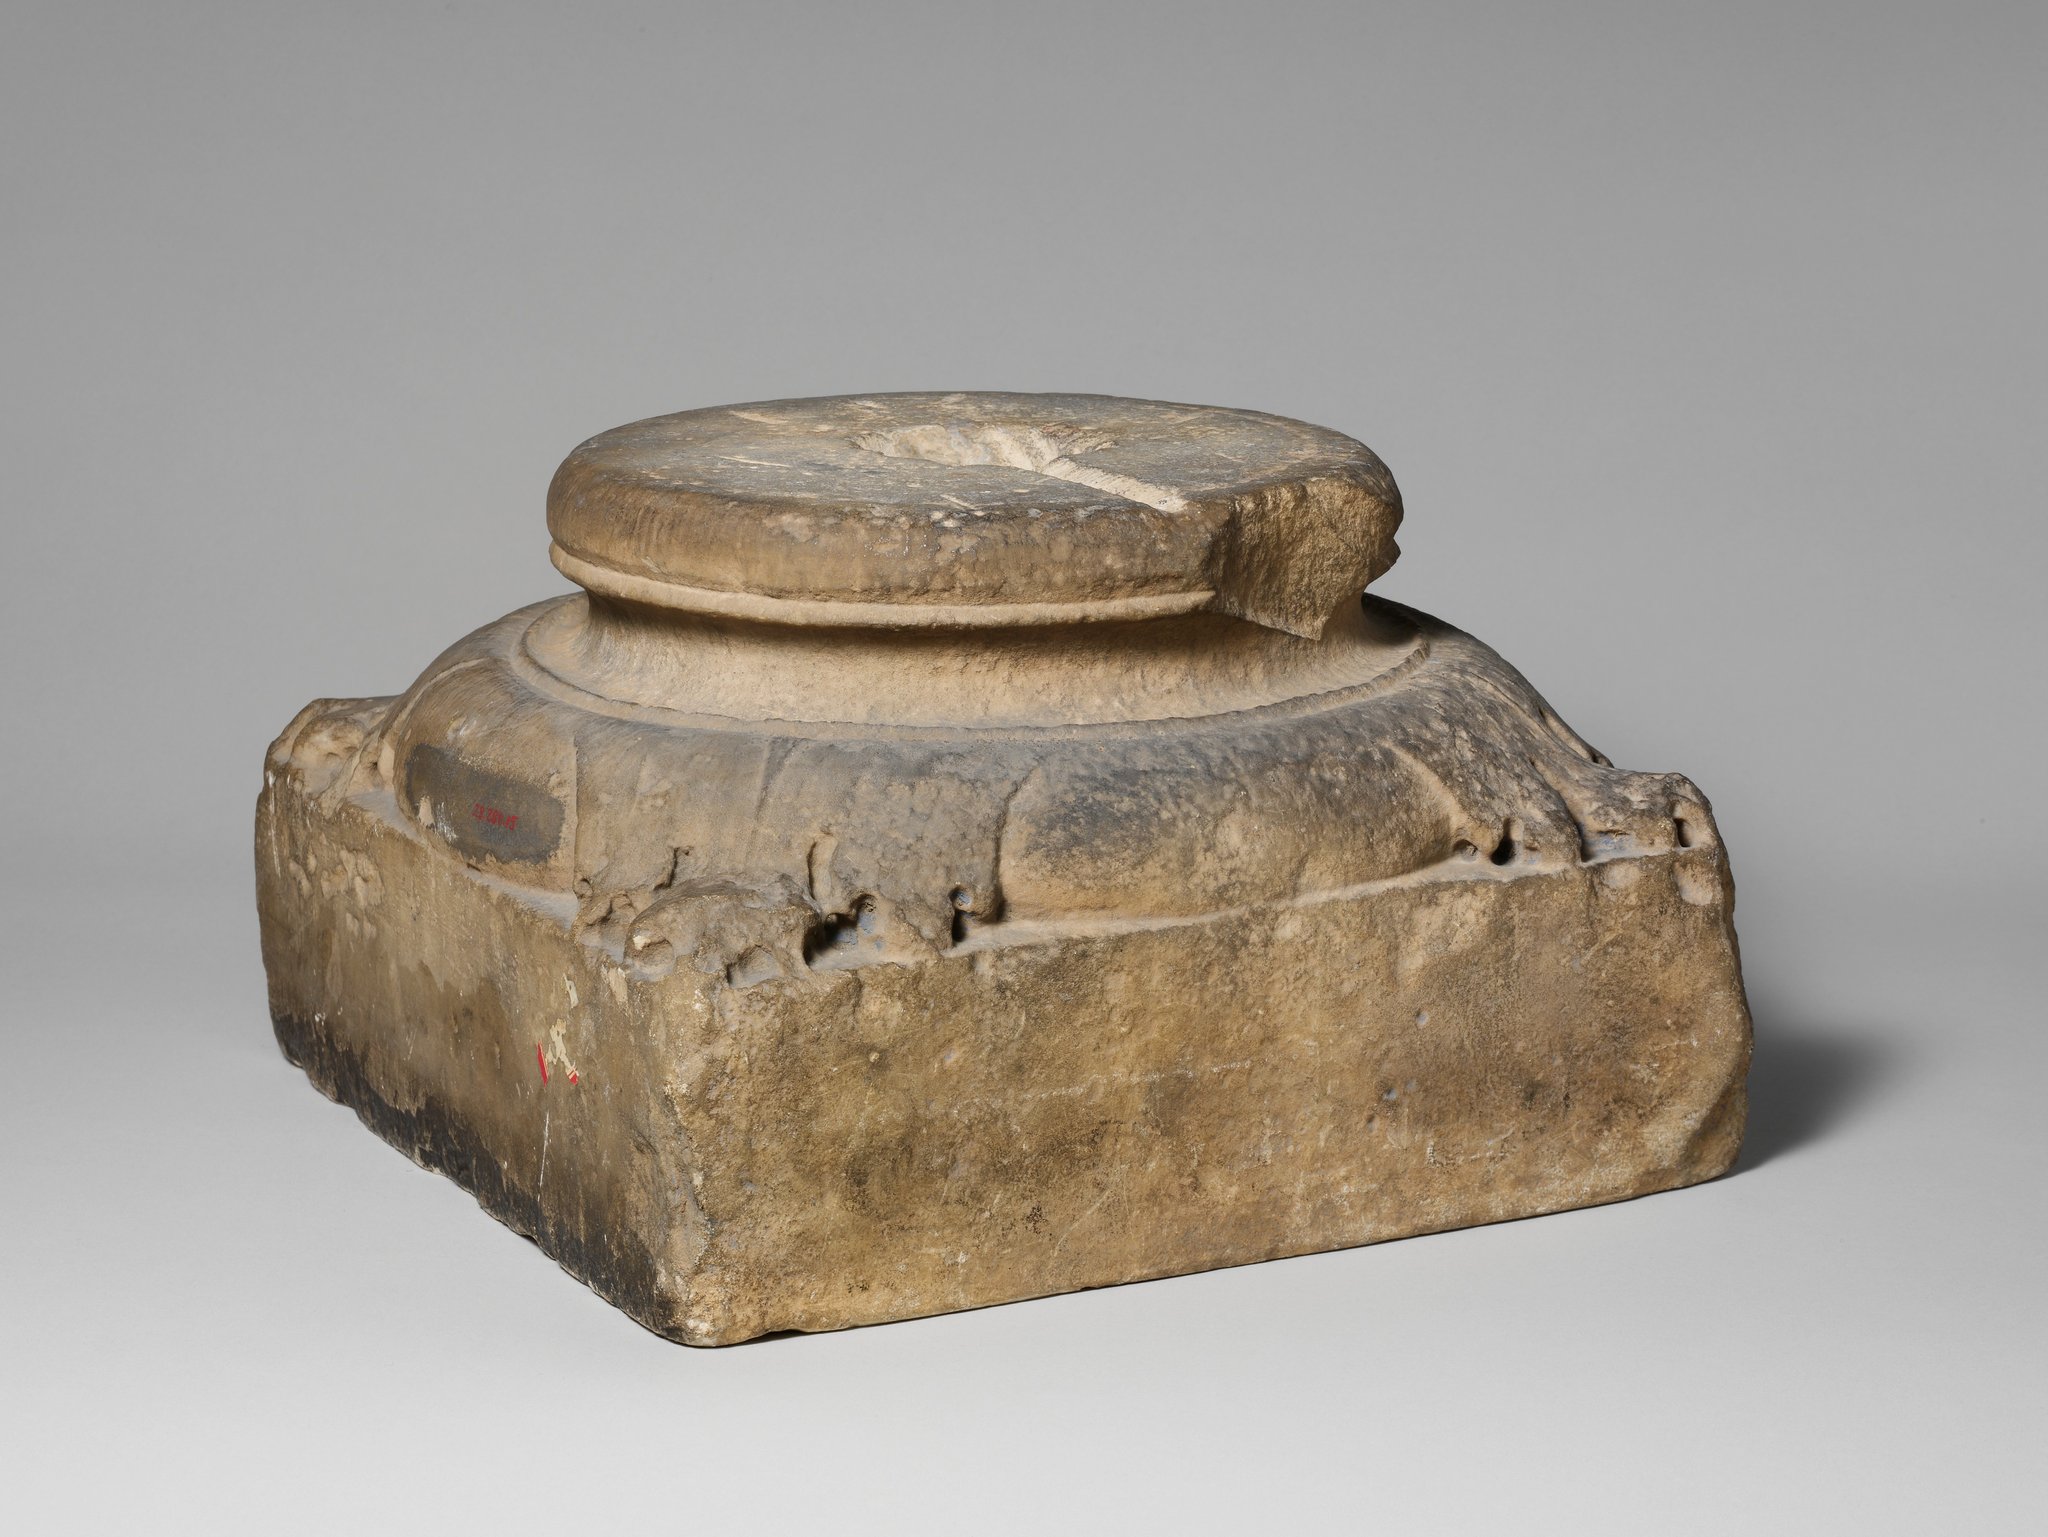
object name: column base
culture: south italian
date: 1167-1233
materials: marble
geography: italy